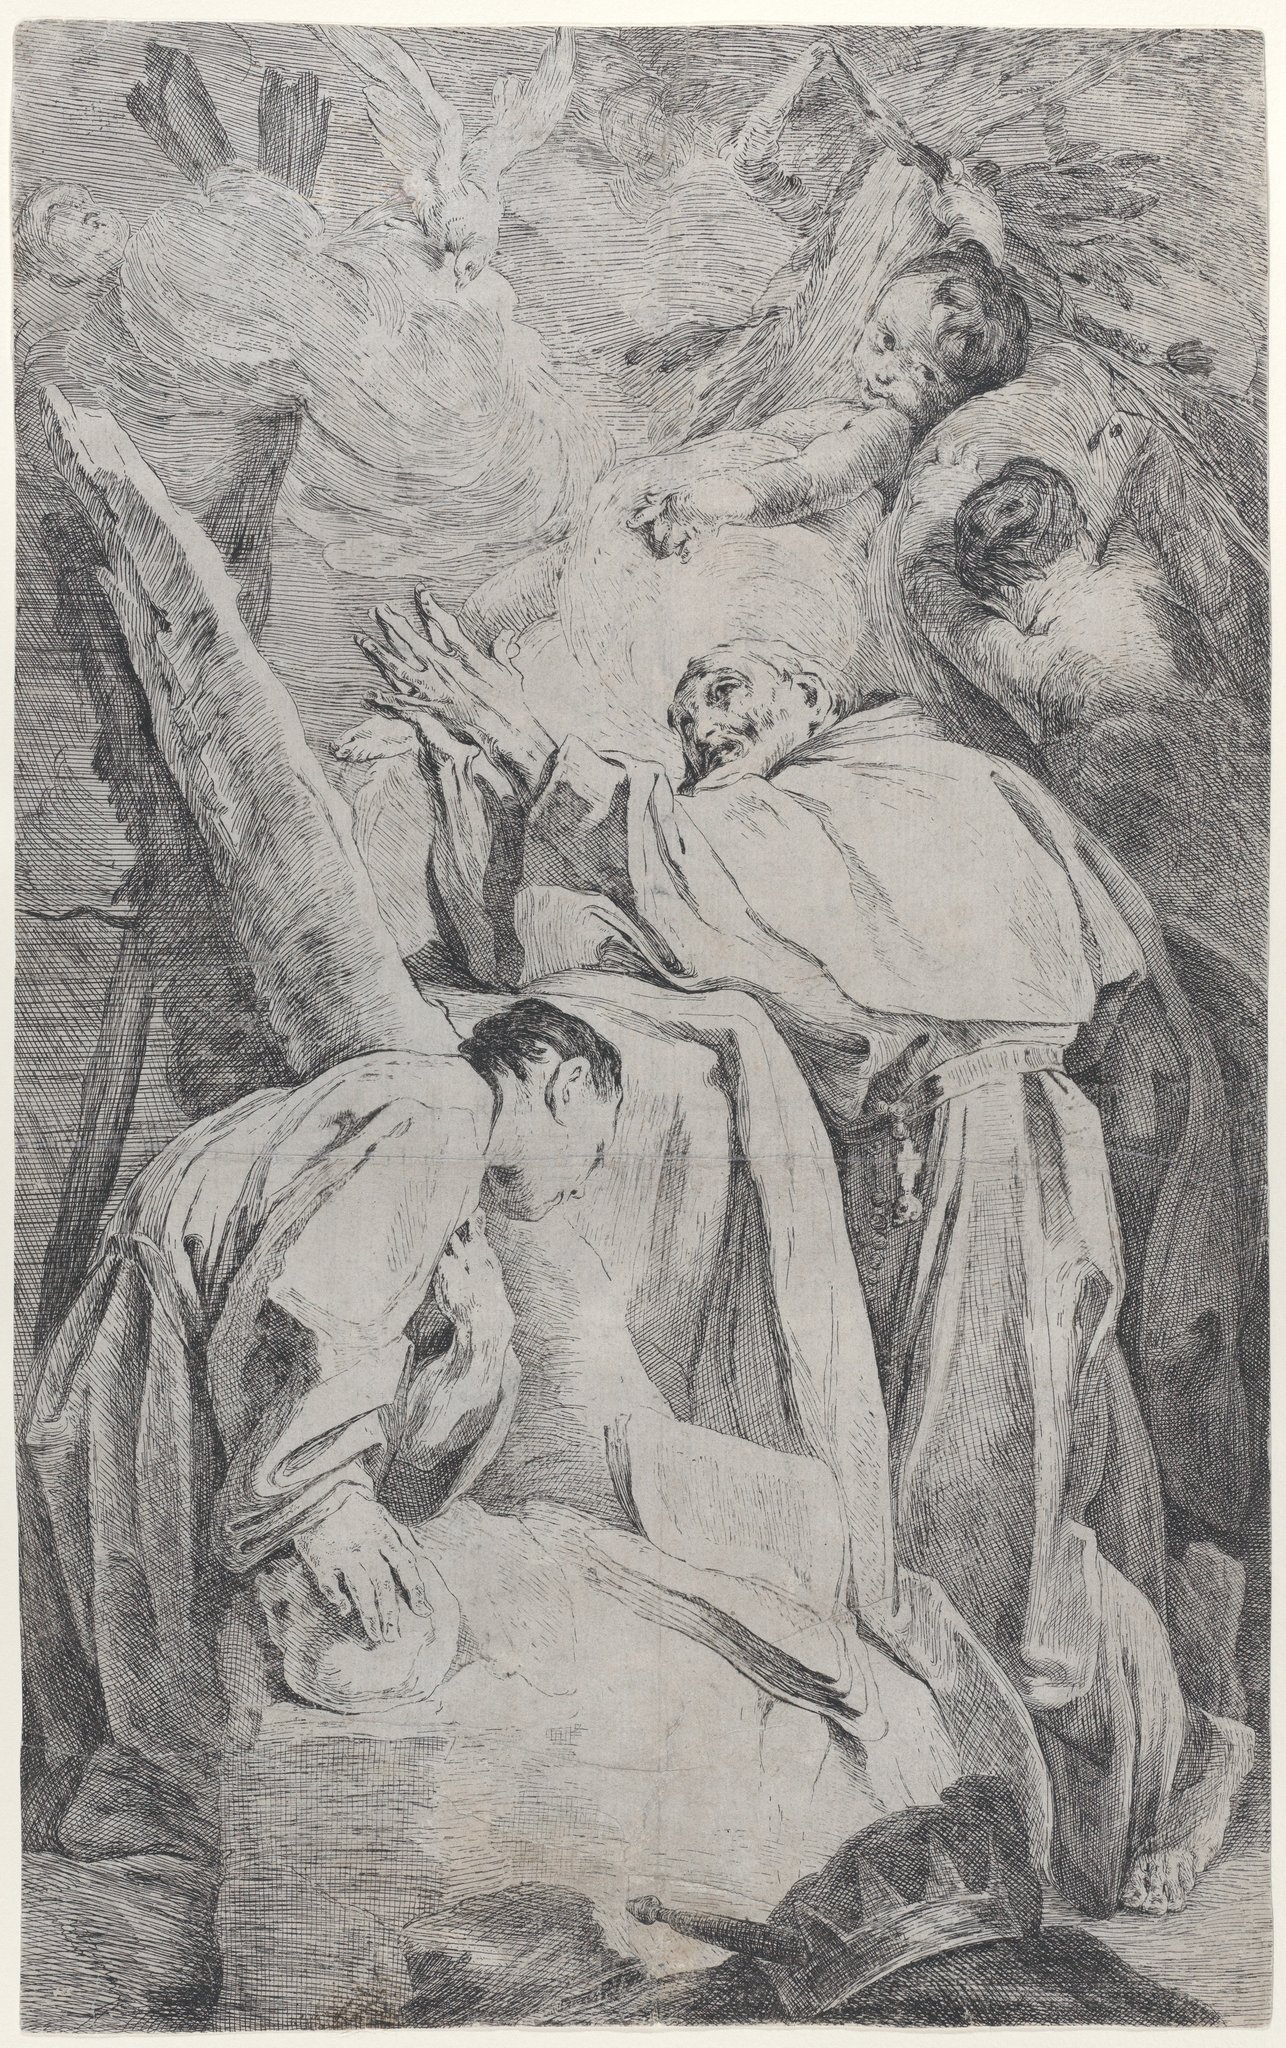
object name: print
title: Ecstasy of the Blessed Piero Gambacorti of Pisa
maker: federico bencovich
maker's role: artist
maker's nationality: italian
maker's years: 1677-1756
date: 1725-1728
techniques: etching